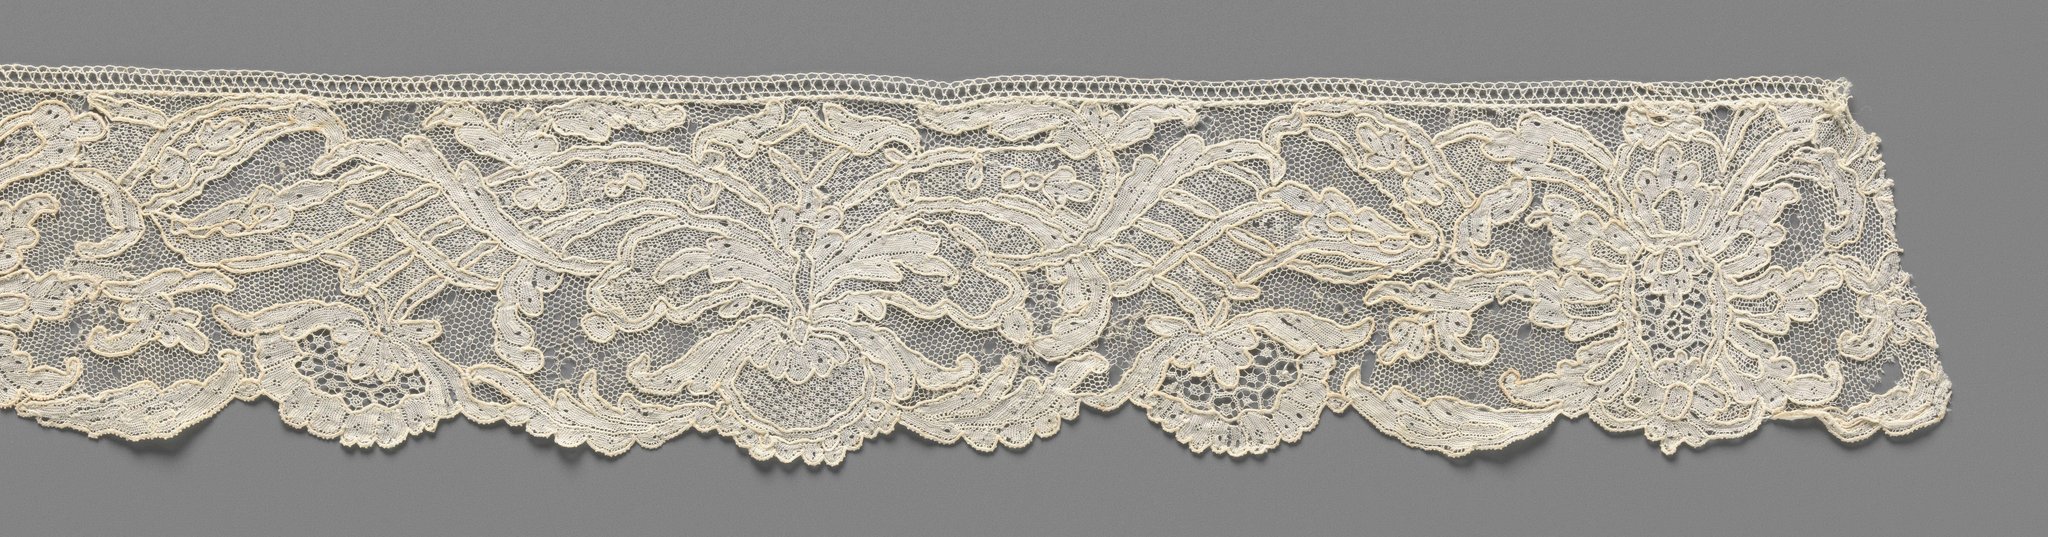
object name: strip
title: Strook naaldkant met symmetrische composities met bloemen en cartouches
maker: Anonymous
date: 1725-1749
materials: linen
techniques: lace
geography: france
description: Strook naturelkleurige naaldkant: Alençon-kant. Het zich herhalende patroon bestaat uit twee symmetrische bloemmotieven. Een ovaal cartouche bekroond door een rozetbloempje en met uitstralende gevederde bladeren. En een breed vlindervormig motief dat is opgebouwd uit golvende lijnen en omkrullende bladeren met direct daaronder een ovale bloem, aan weerzijden geflankeerd door een hangende waaiervormige bloem. De motieven zijn opgebouwd uit festonsteken met uitsparingen en voorzien van reliëfcontouren. De motieven zijn met elkaar verbonden door een fijne maasgrond, een Alençon-grond. In de bloemharten en tussen bladeren en andere onderdelen van de motieven zijn verschillende siergronden toegepast, waaronder een diamantgrond. De onregelmatige schulpenrand komt voort uit het patroon en is afgewerkt met picots. De bovenzijde van de strook is recht afgewerkt met een geklost bandje.